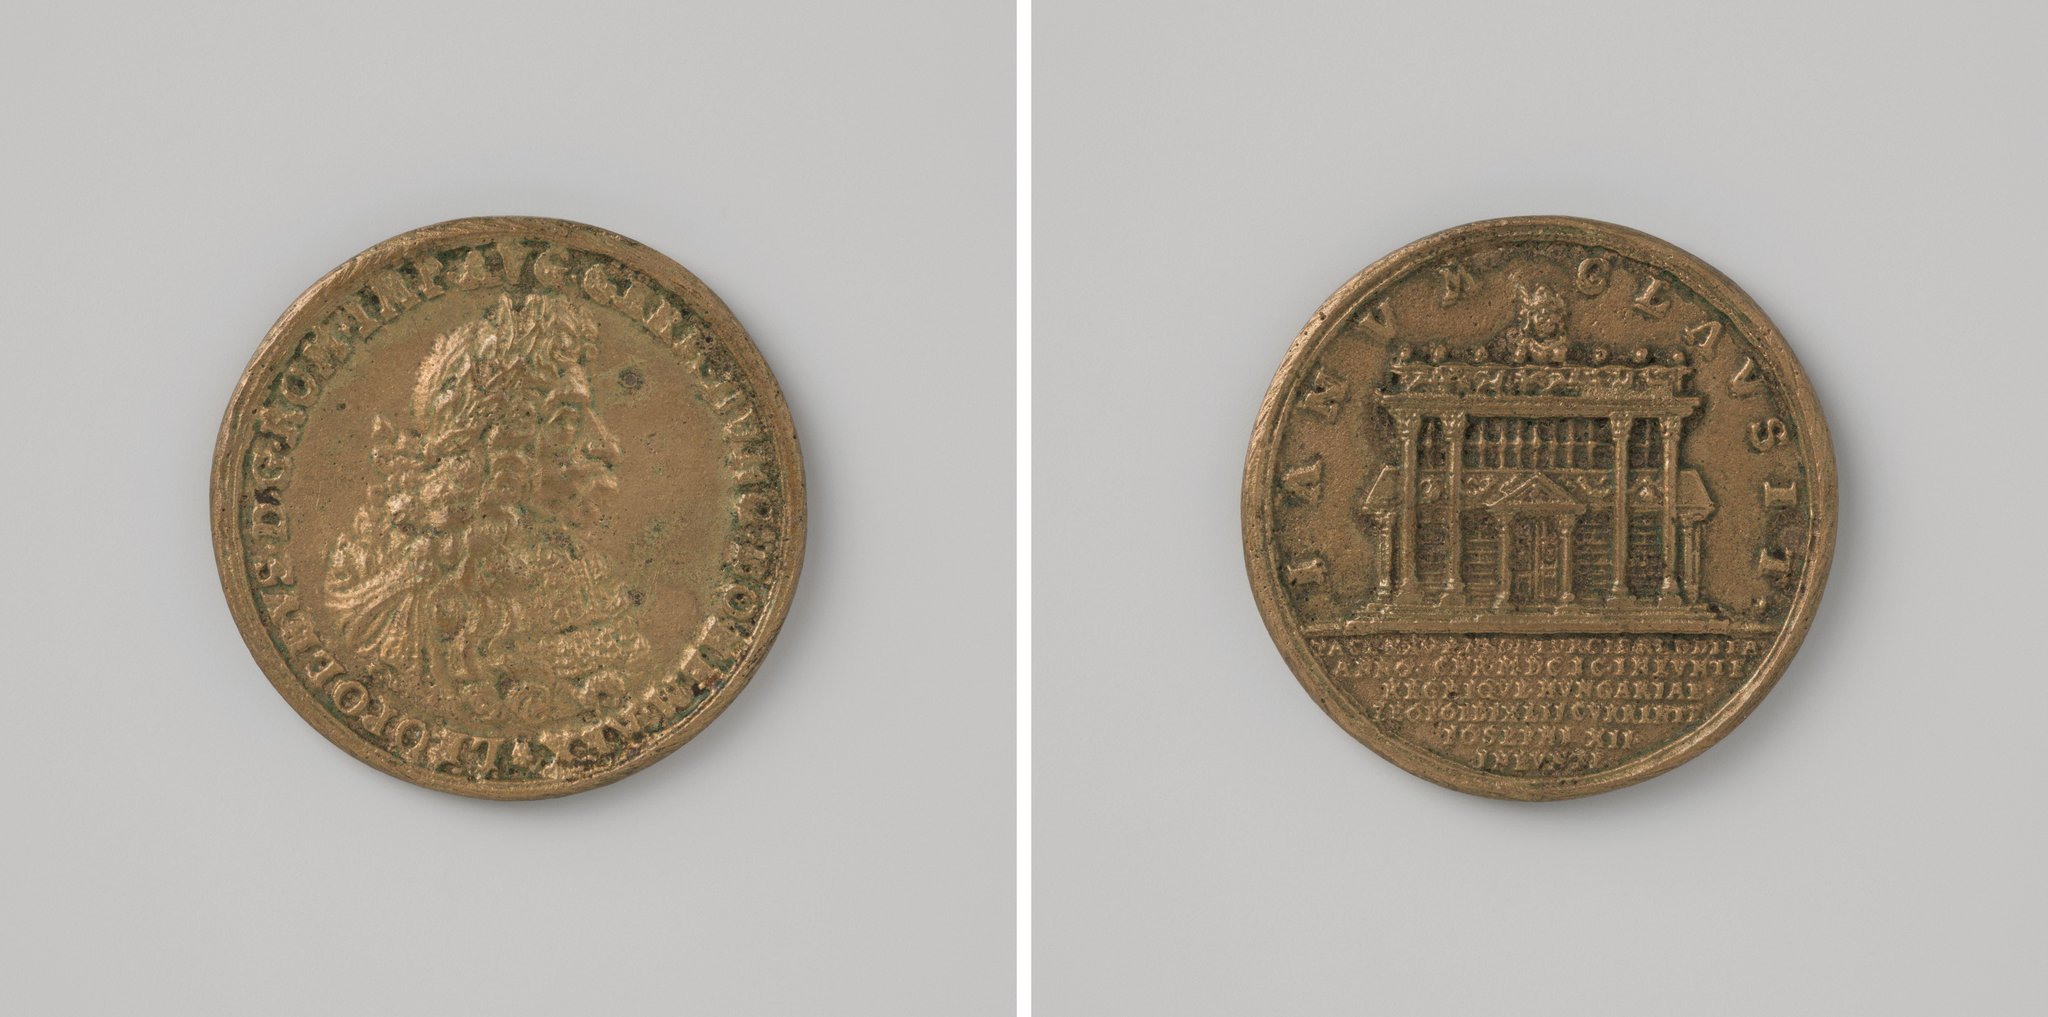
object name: history medal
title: Verdrag van Karlowitz tussen de keizer, Polen, Rusland, Venetië en Turkije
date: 1699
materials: bronze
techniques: striking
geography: gotha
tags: vienna, leopold i (keizer van duitsland), poland, venice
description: Bronzen penning. Voorzijde: borststuk man met lauwerkrans binnen omschrift. Keerzijde: gesloten tempel van Janus binnen omschrift; afsnede: opschrift